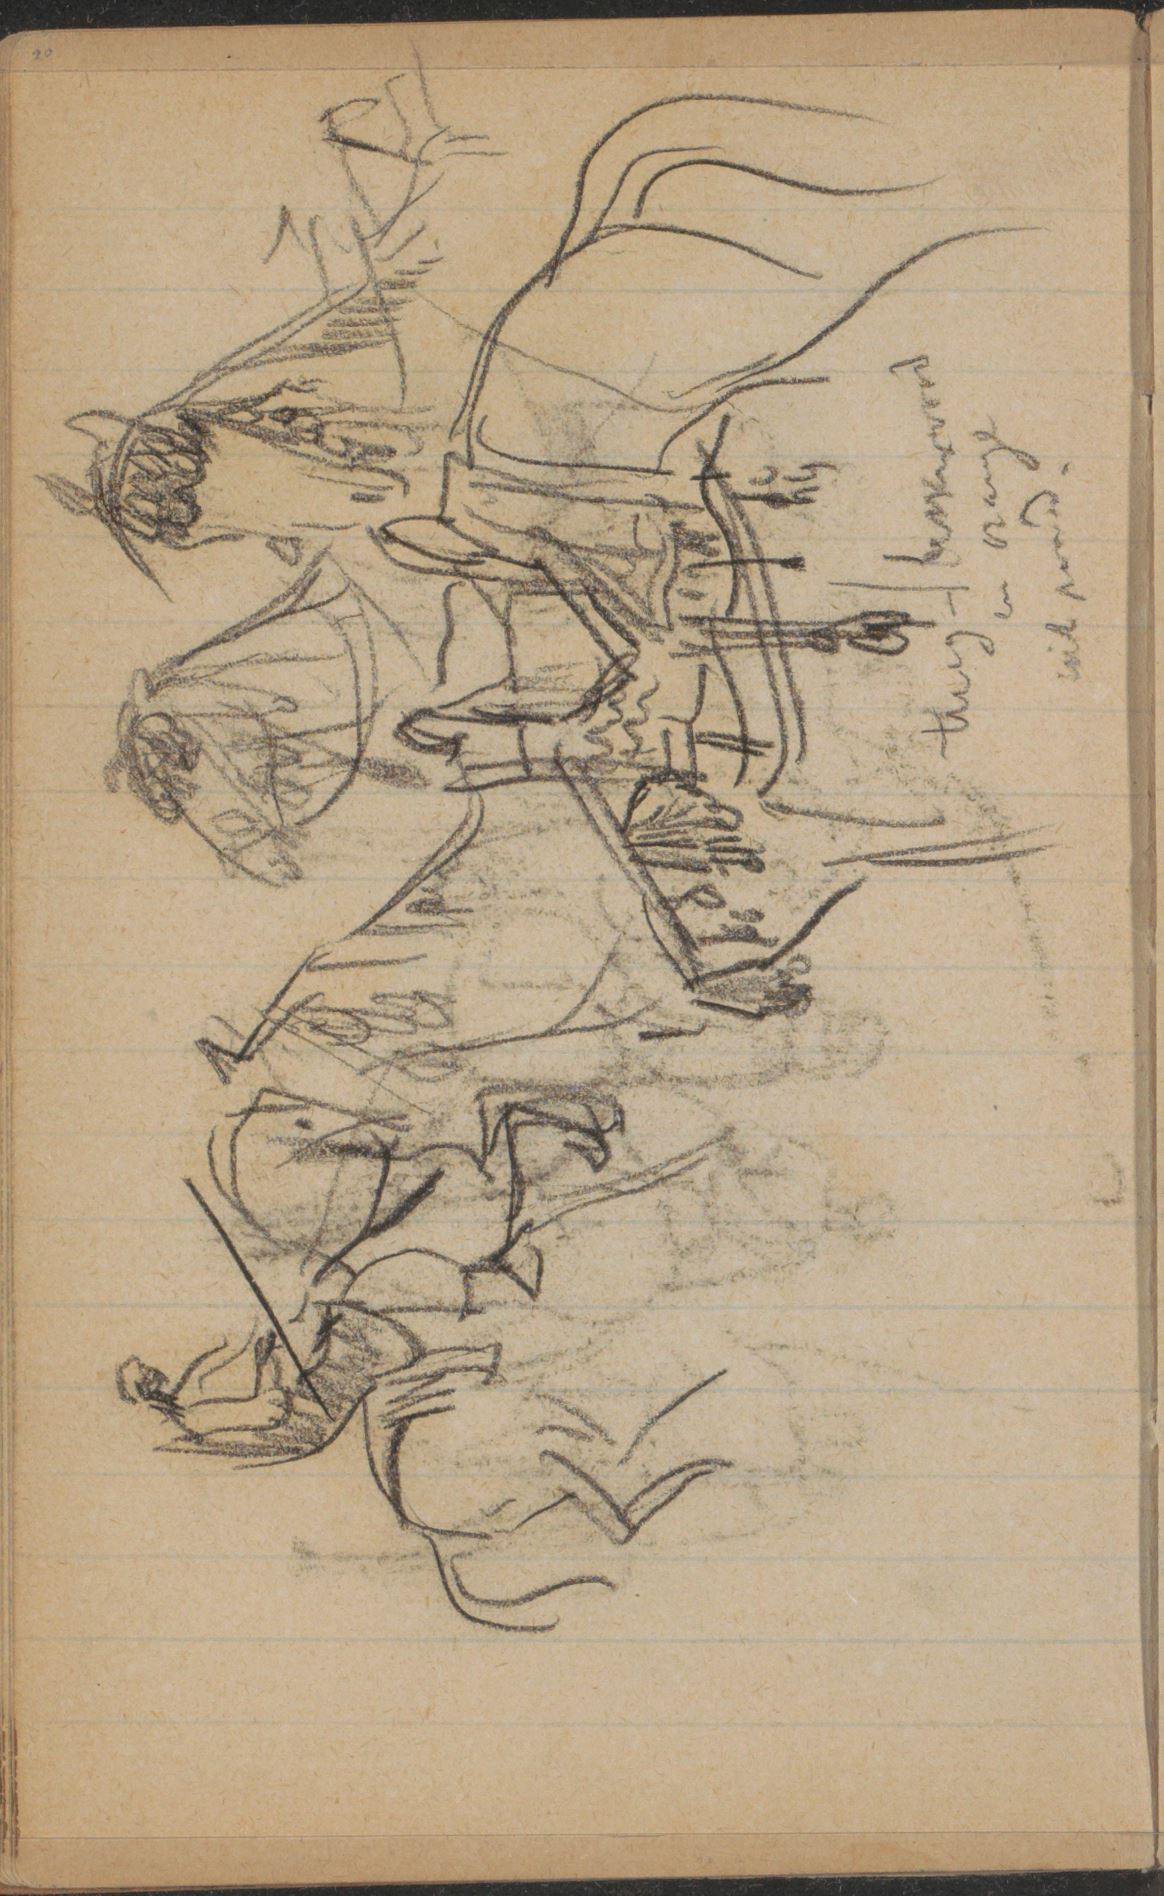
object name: sketchbook leaf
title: Ruiter en paarden met versierde tuigen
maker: marius bauer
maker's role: draughtsman, print maker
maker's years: 1867-1932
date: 1894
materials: chalk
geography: egypt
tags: riding a horse, ass, or mule; rider, horseman, saddle and bridle (saddlery), africans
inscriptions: kleurnotitie, handgeschreven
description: Pagina 20 uit een schetsboek met 48 bladen.